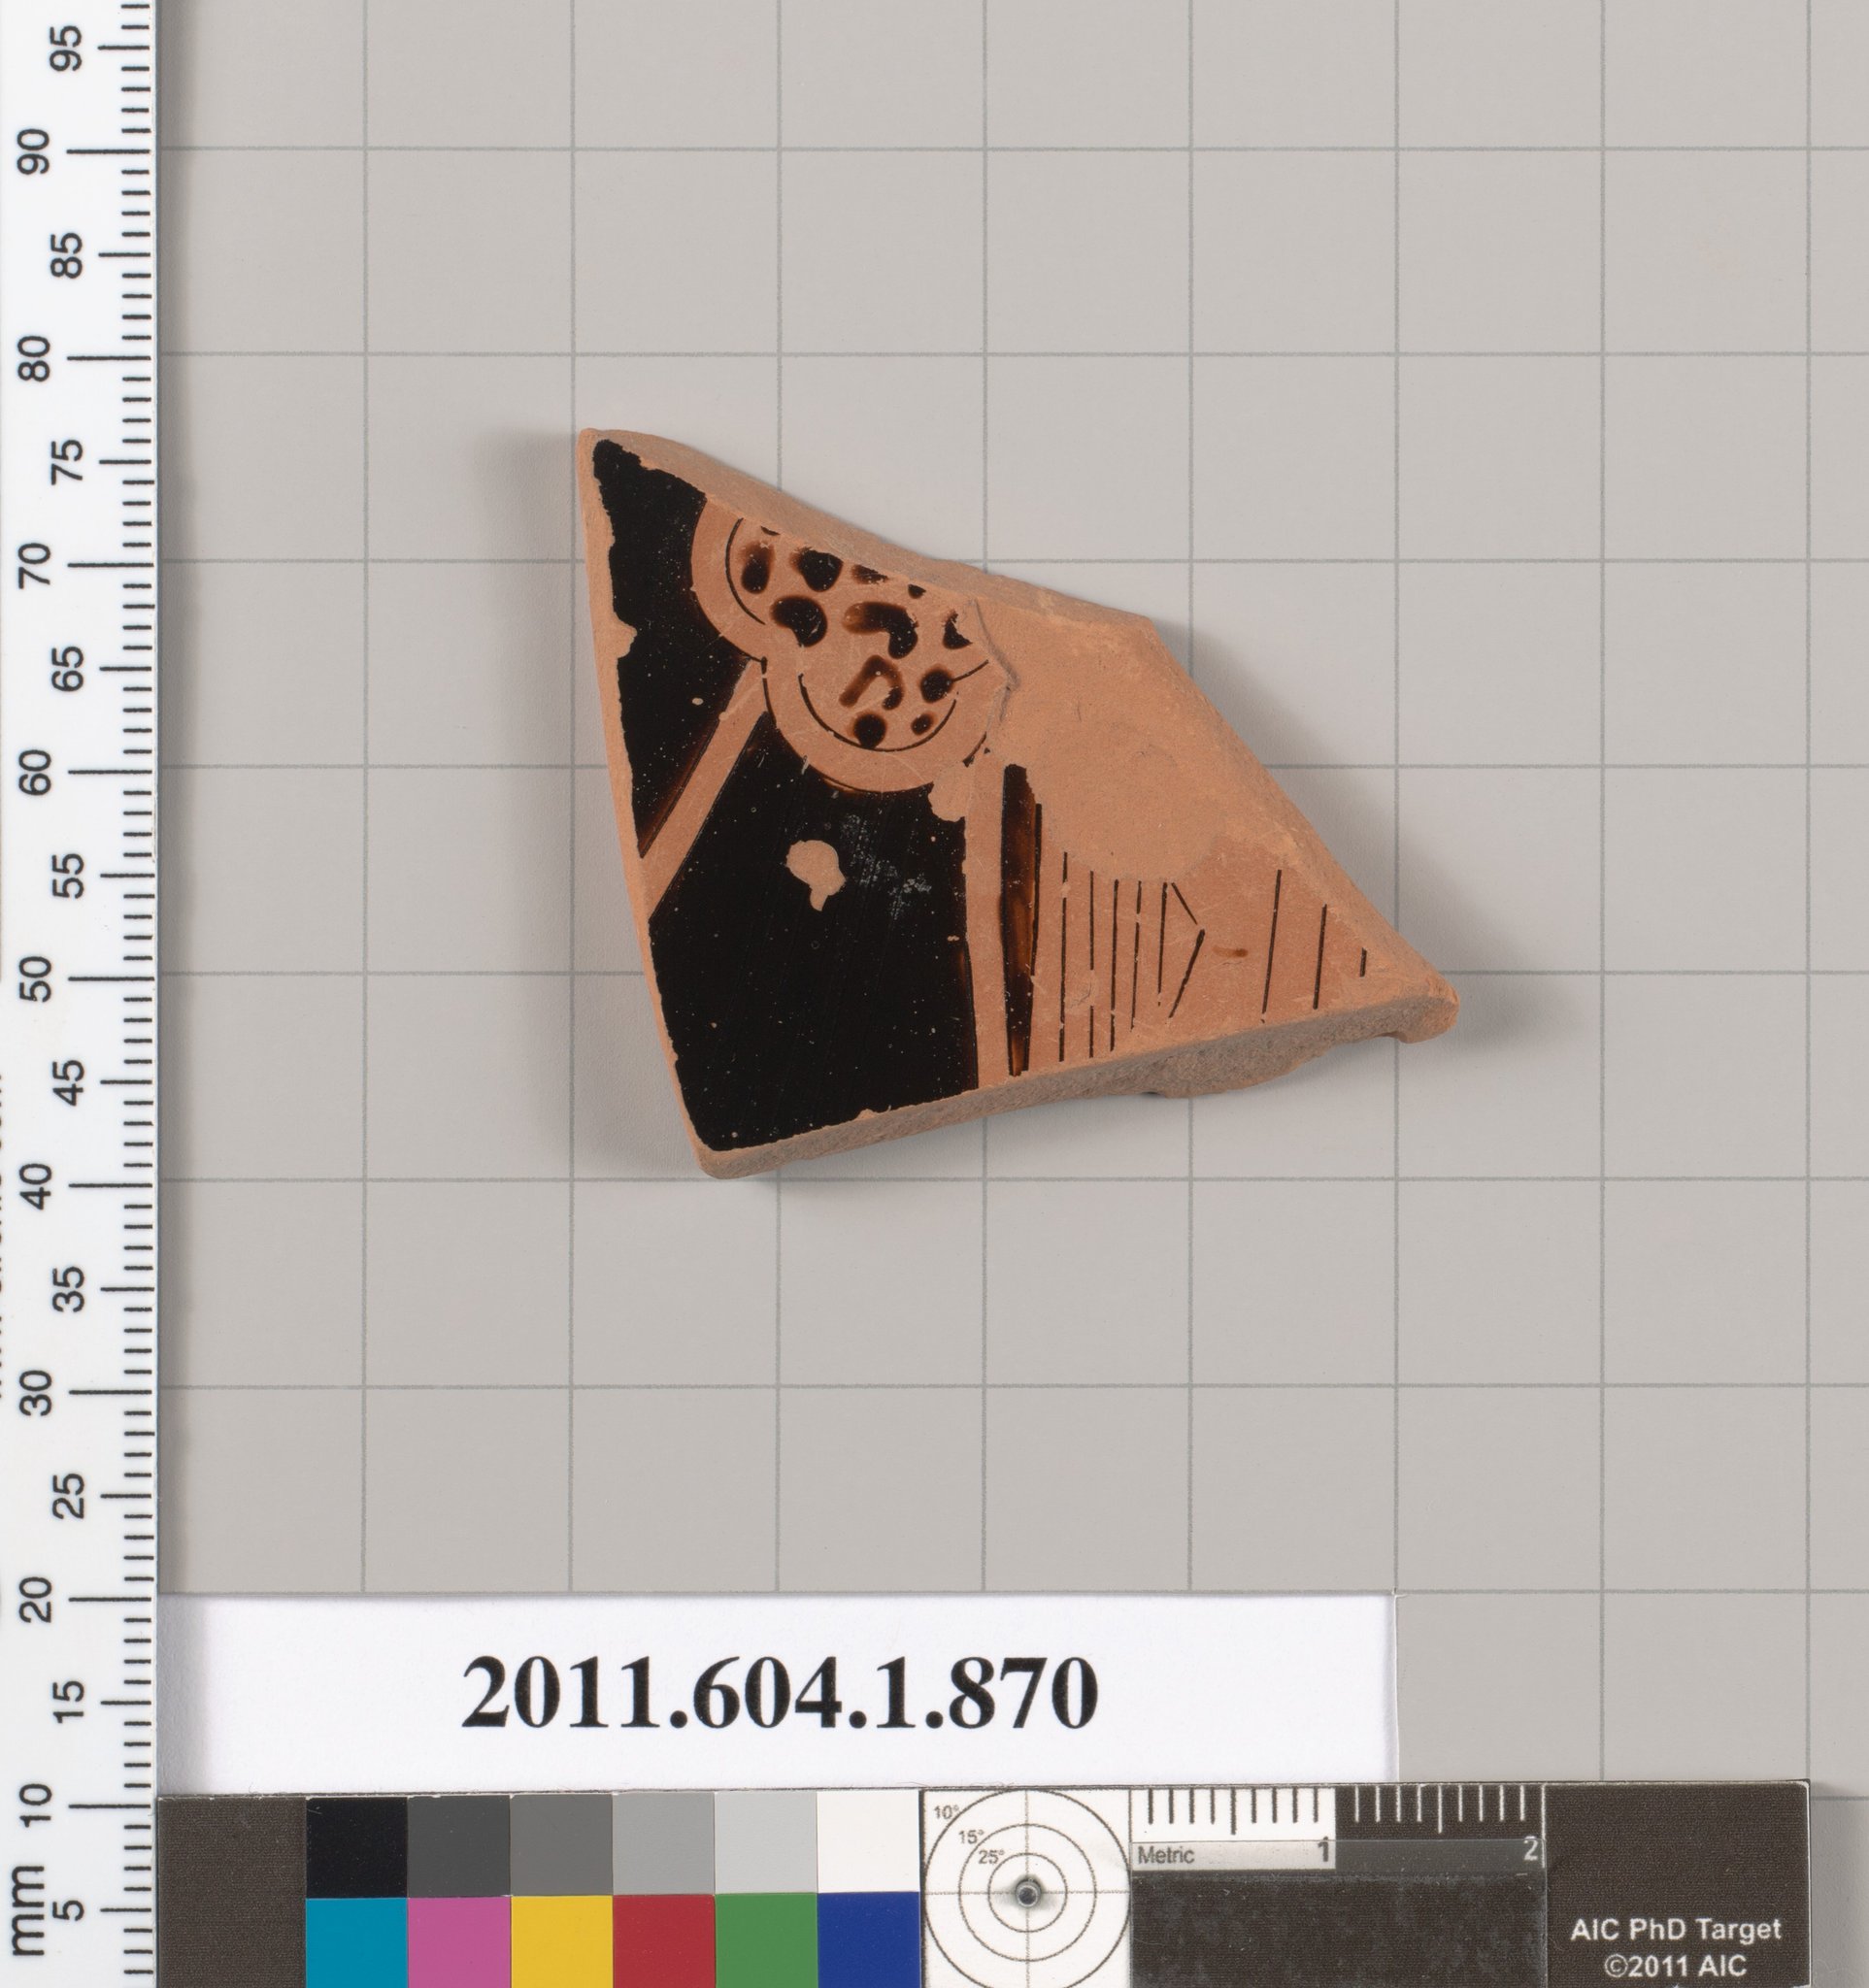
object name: kylix fragment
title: Terracotta fragment of a kylix (drinking cup)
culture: greek, attic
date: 480-470 BCE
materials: terracotta